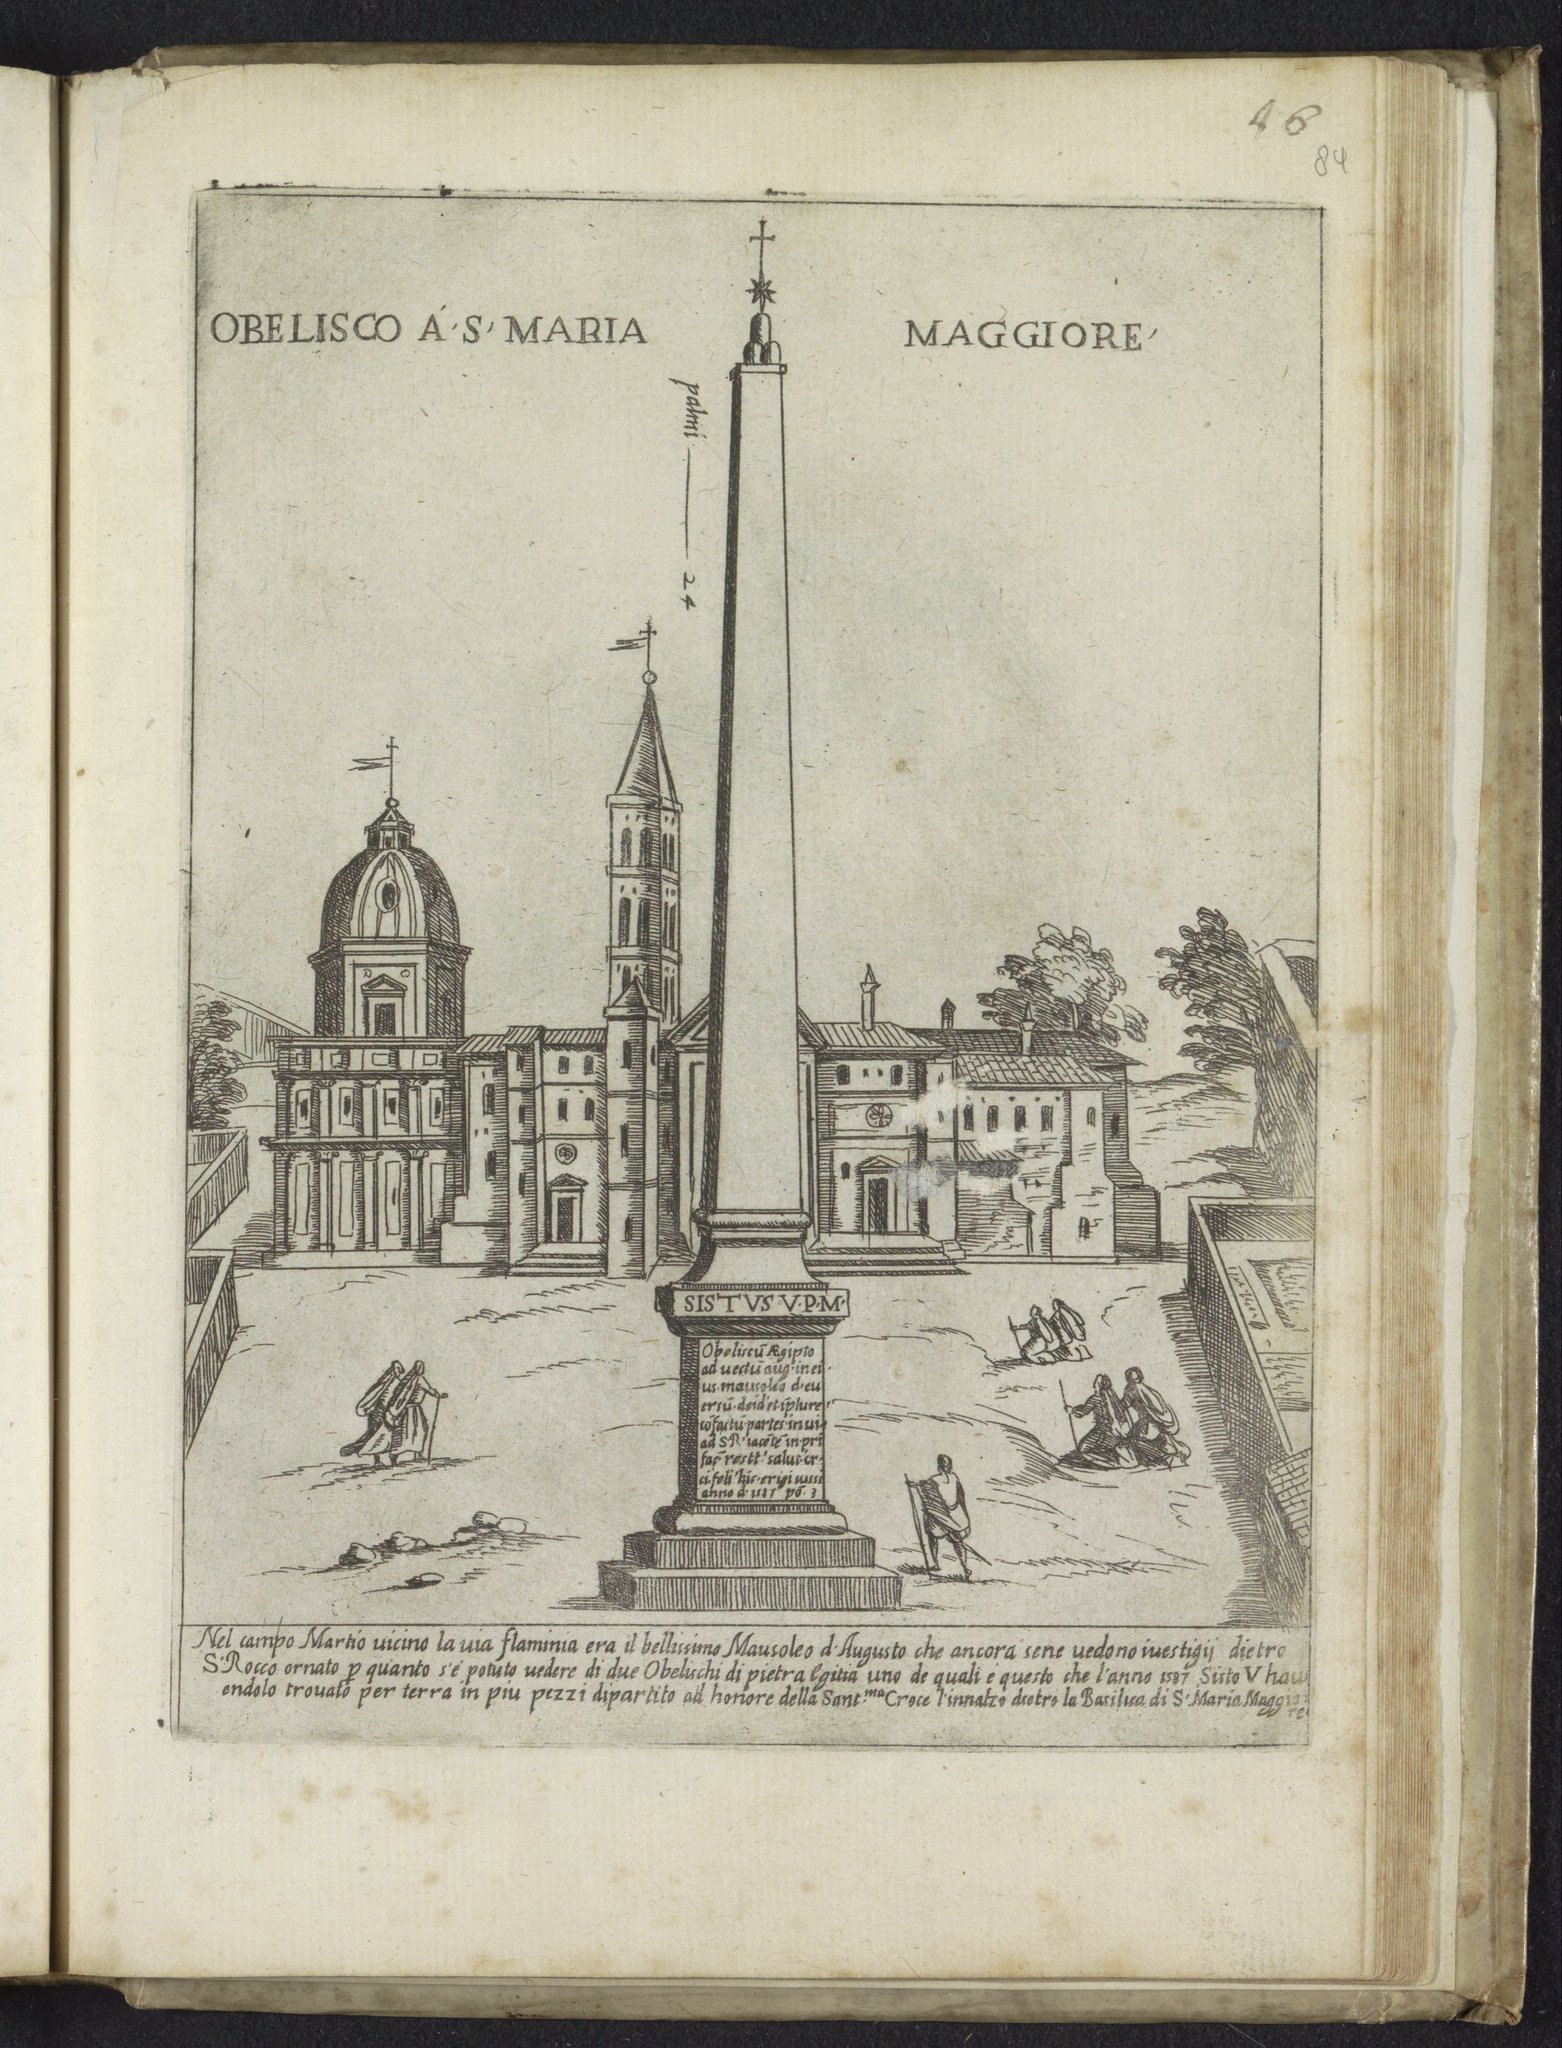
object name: print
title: Ornamenti di fabriche antichi et moderni dell' alma citta di Roma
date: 1576-1618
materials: paper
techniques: etching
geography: rome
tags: obelisk, needle, church (exterior), rome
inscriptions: number: ‘46’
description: De Colonna della Pace (obelisk) op het Piazza di Santa Maria Maggiore voor de Santa Maria Maggiore te Rome. Italiaanse tekst in ondermarge. Prent maakt deel uit van een album.